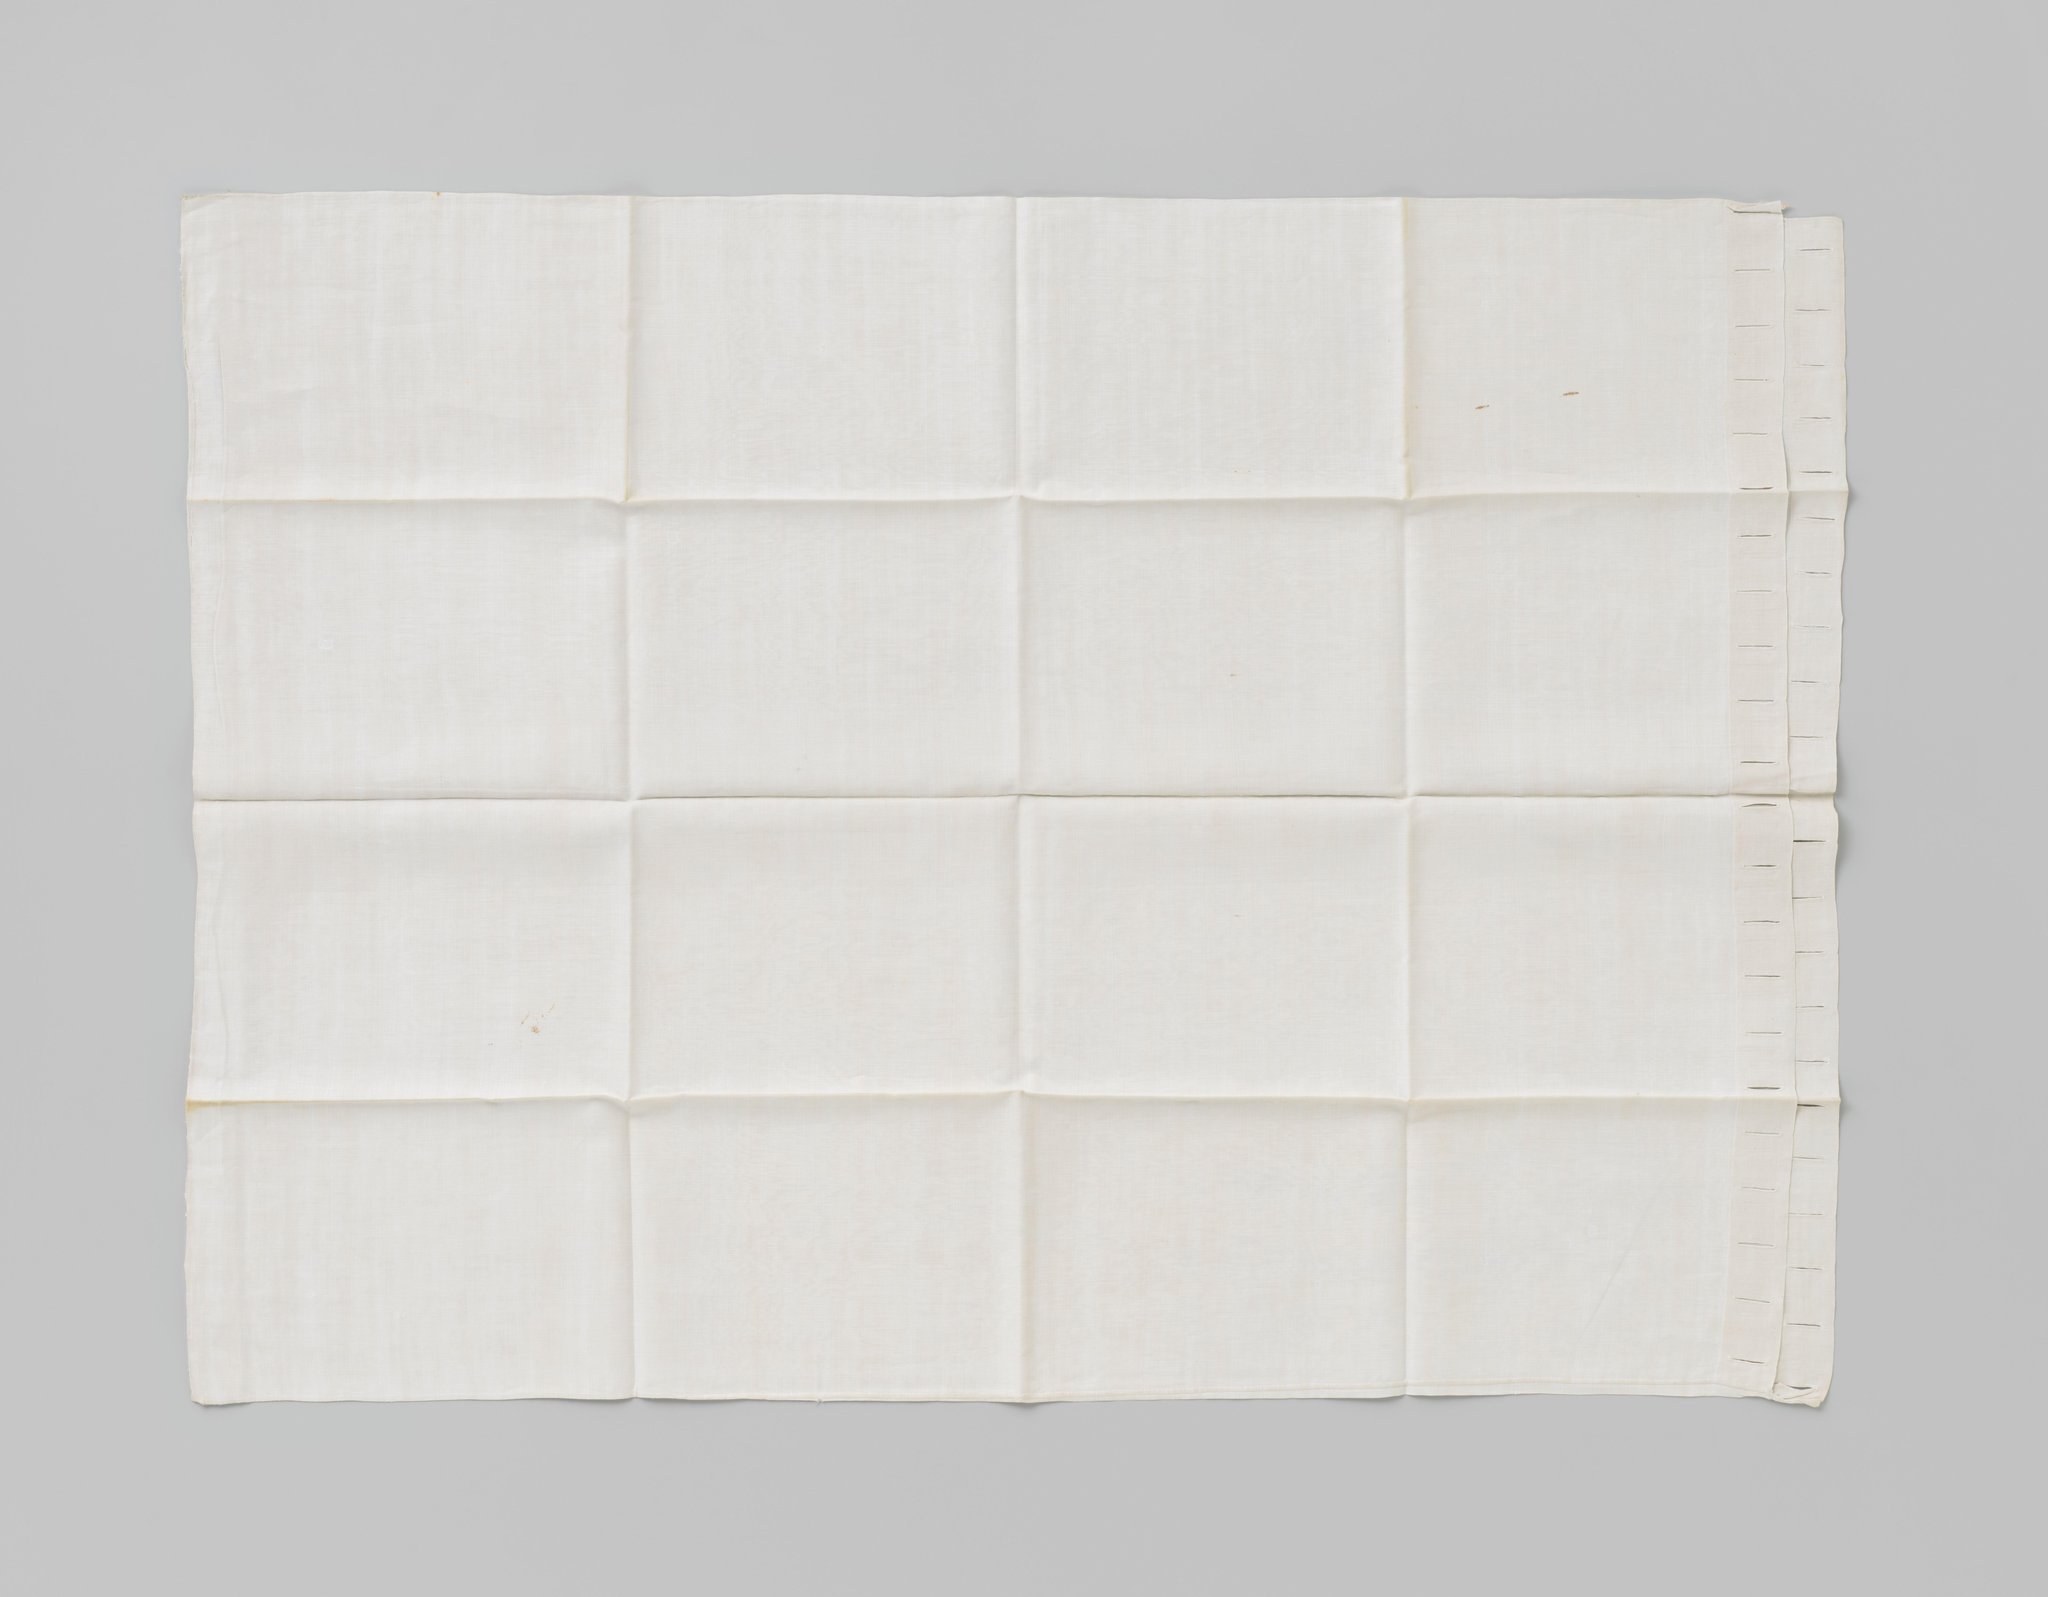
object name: sloop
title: Sloop van wit linnen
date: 1773-1776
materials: linen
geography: northern netherlands